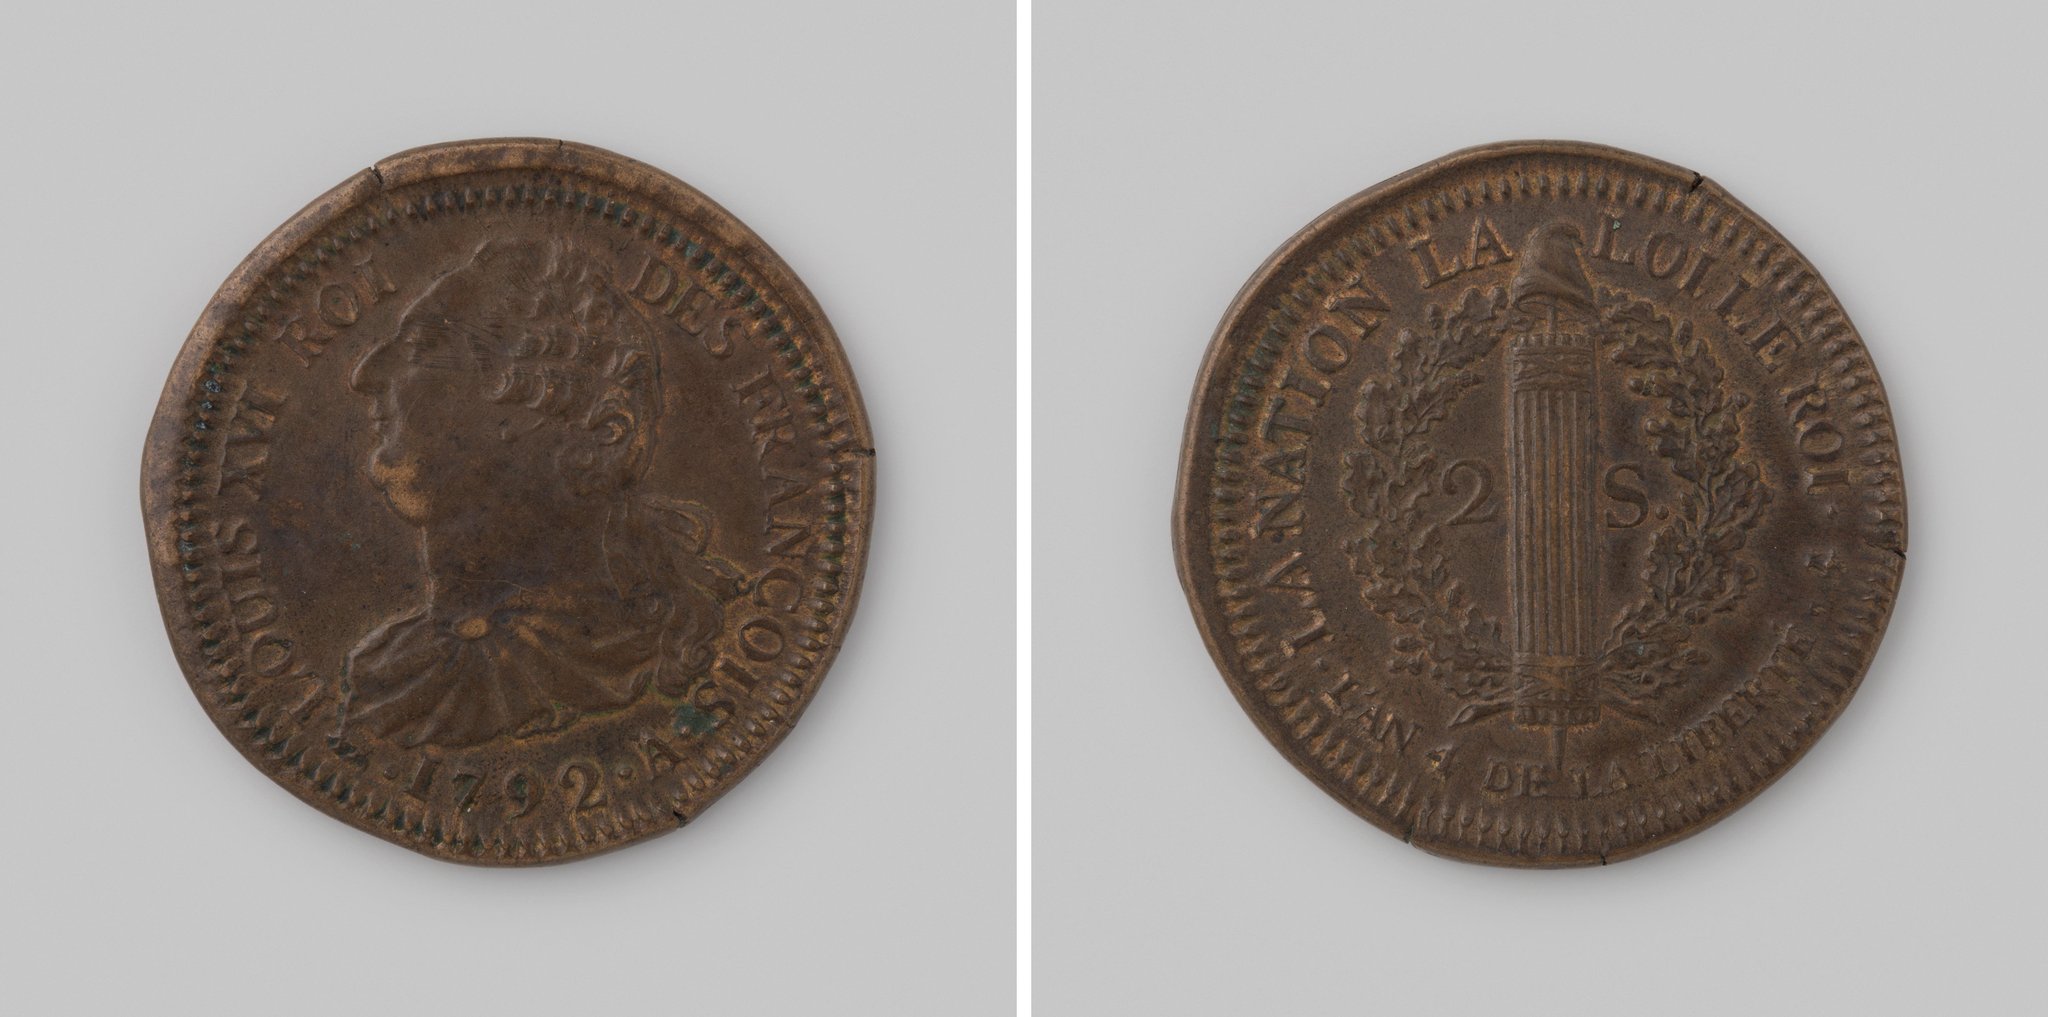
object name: coin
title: Frankrijk, 2 sols, Lodewijk XVI, 1792 A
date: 1792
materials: bronze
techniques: striking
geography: paris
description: Bronzen munt. Voorzijde: borstbeeld van de koning naar links. Daaronder jaartal met rechts daarvan letter A [=Parijs]. Keerzijde: binnen twee samengebonden eikentakken staande pijlenhouder met pijl, waarop vrijheidshoed. Links en rechts van houder waarde-aanduiding. Onderaan jaartal 4 in nieuwe telling. Gladde rand.